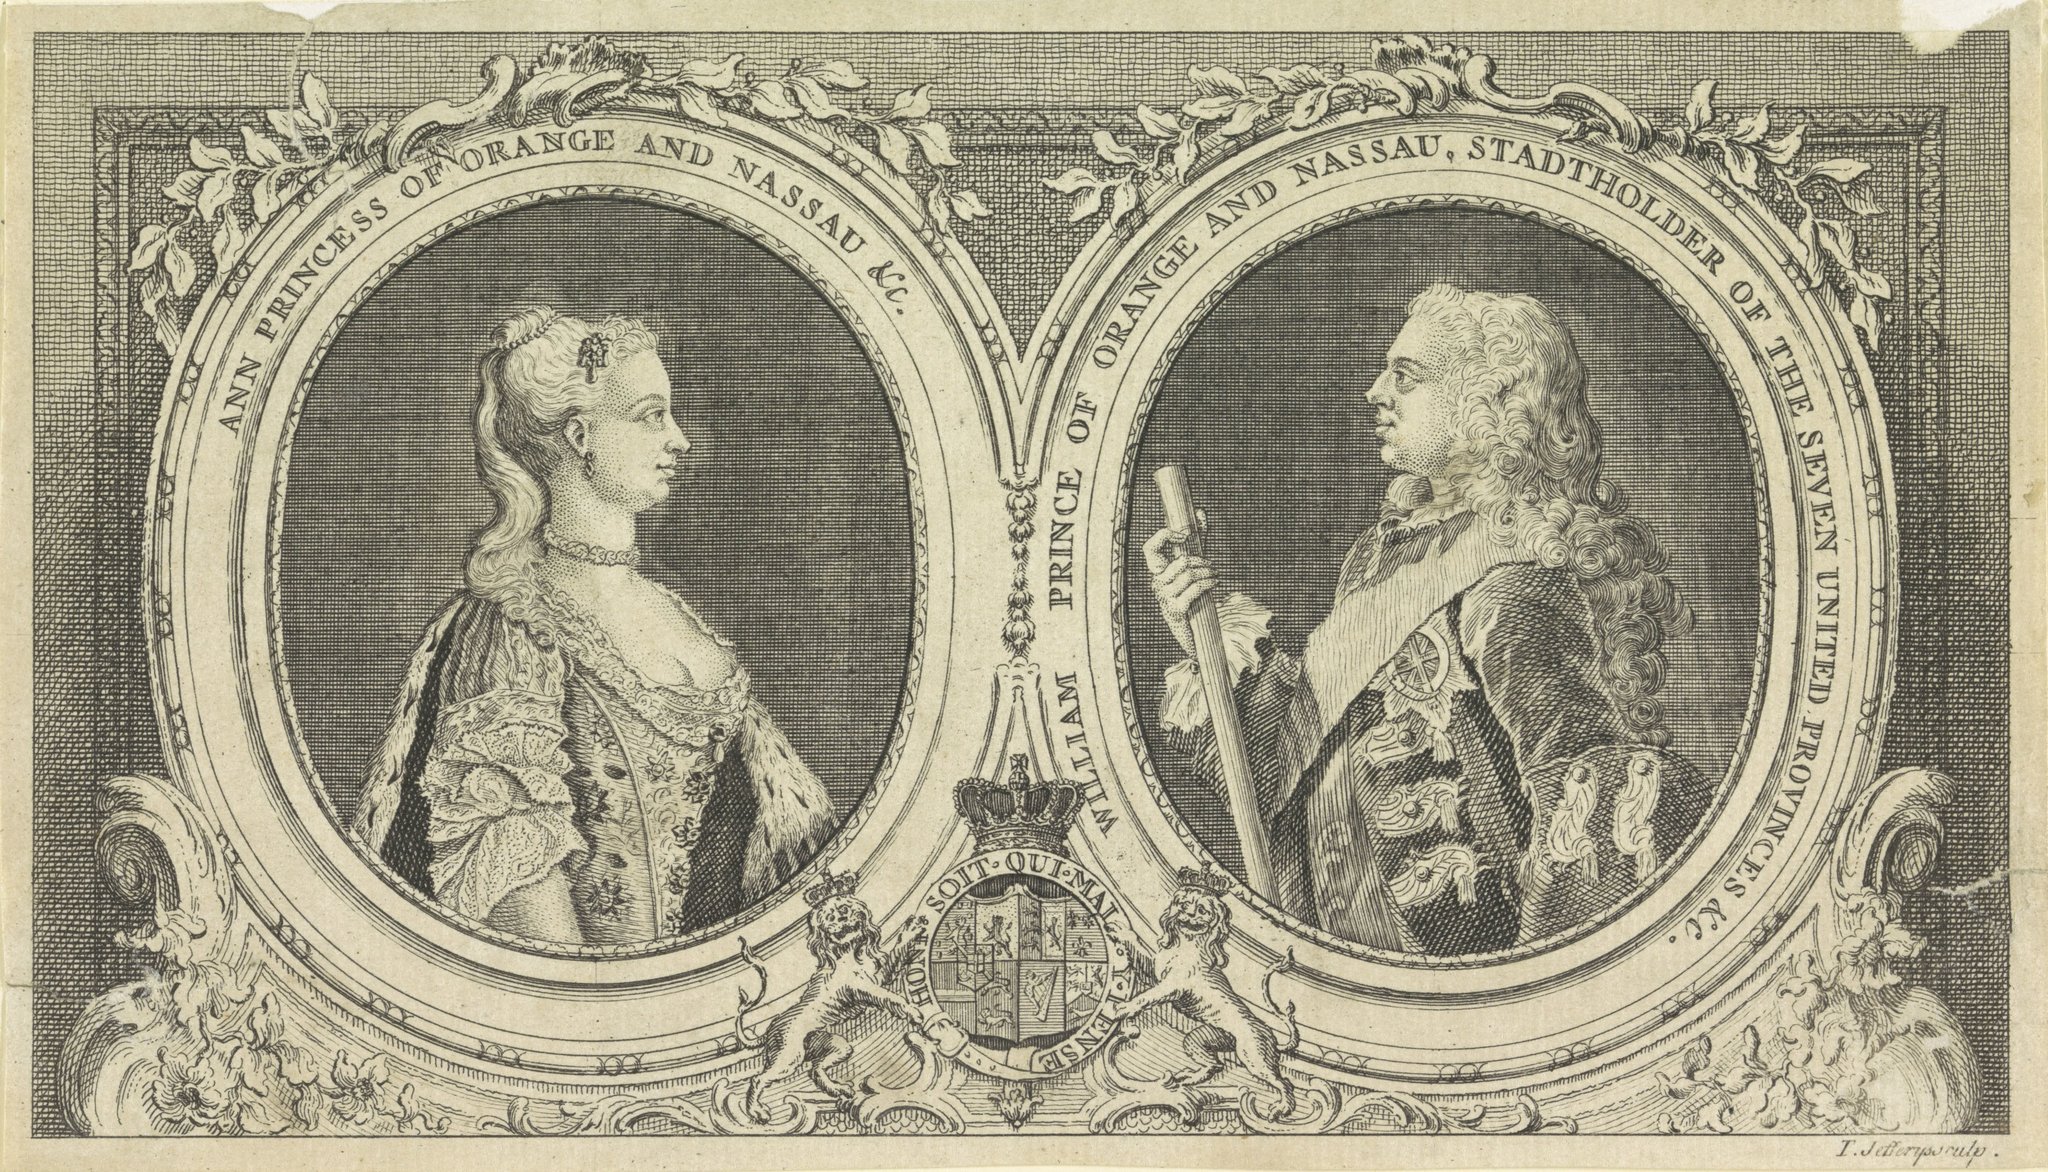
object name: print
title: Portretten van Willem IV, prins van Oranje-Nassau, en Anna van Hannover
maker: t. jefferys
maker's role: publisher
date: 1747-1799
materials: paper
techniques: engraving, etching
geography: low countries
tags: willem iv (prins van oranje-nassau), the hague, anna van hannover, knighthood order (garter) - insignia of a knighthood order, e.g.: badge, chain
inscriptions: collector's mark: Lugt 2228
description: Portretten van Willem IV en Anna, elk in een geornamenteerd ovaal met randschrift. Midden onder hun wapens met een kroon en twee leeuwen, gedecoreerd met de Kousenband en het devies van de Orde van de Kousenband.